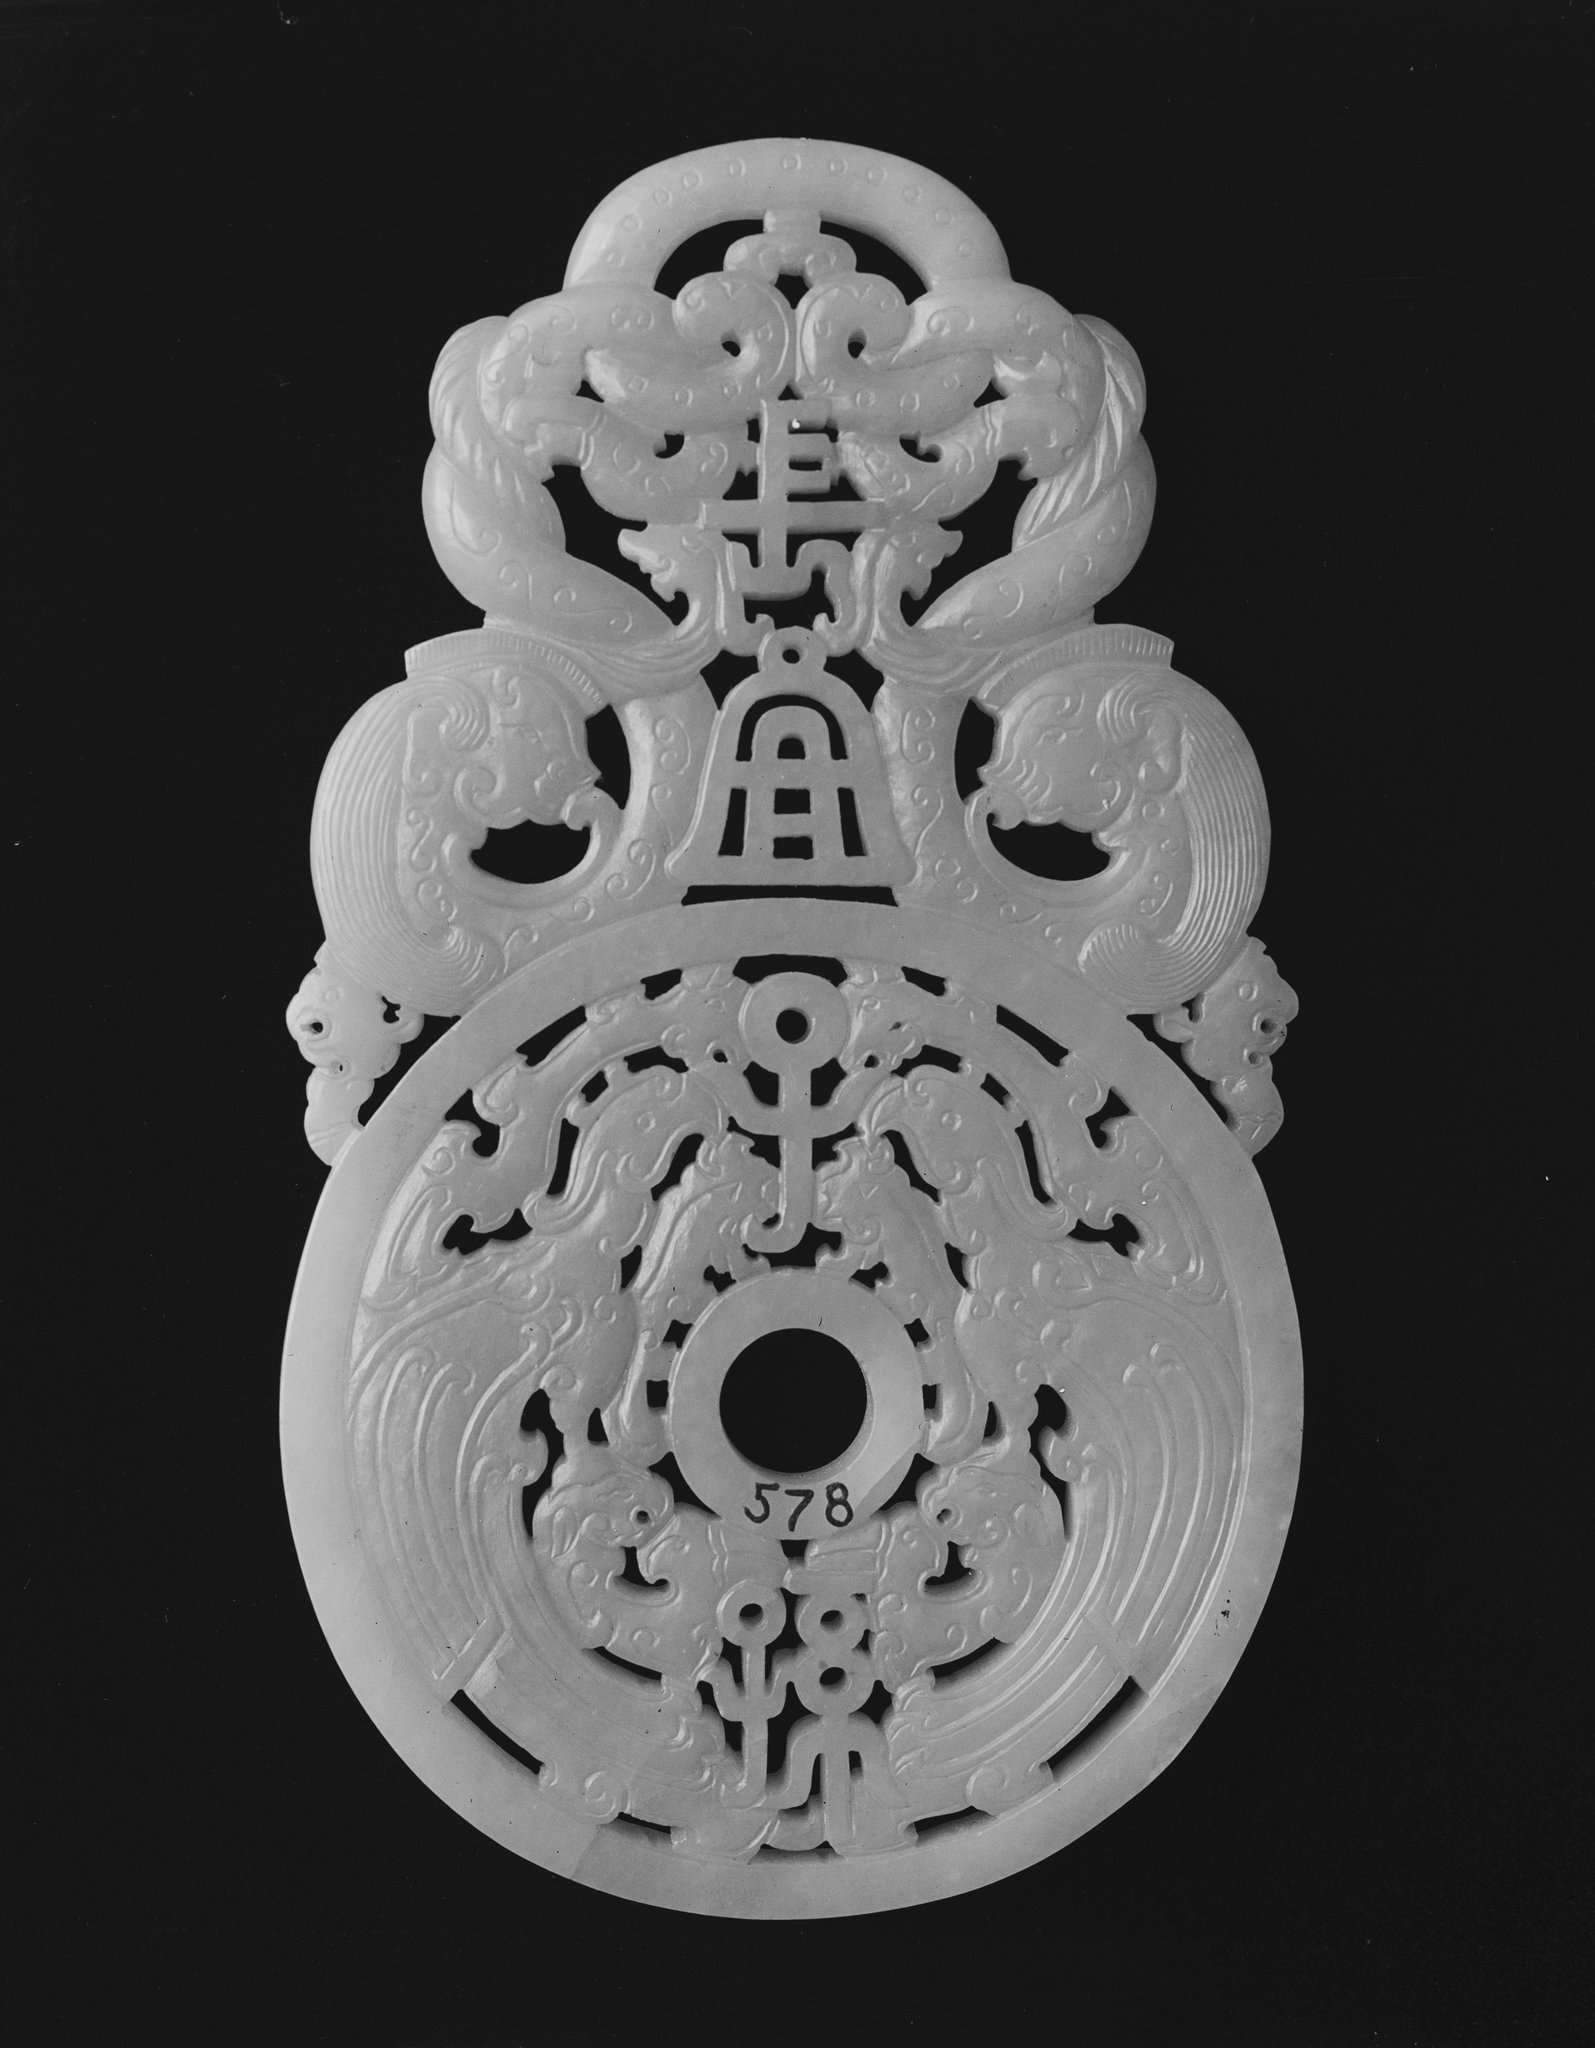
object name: disk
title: Disk with antiquarian theme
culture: chinese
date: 1701-1800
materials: jade